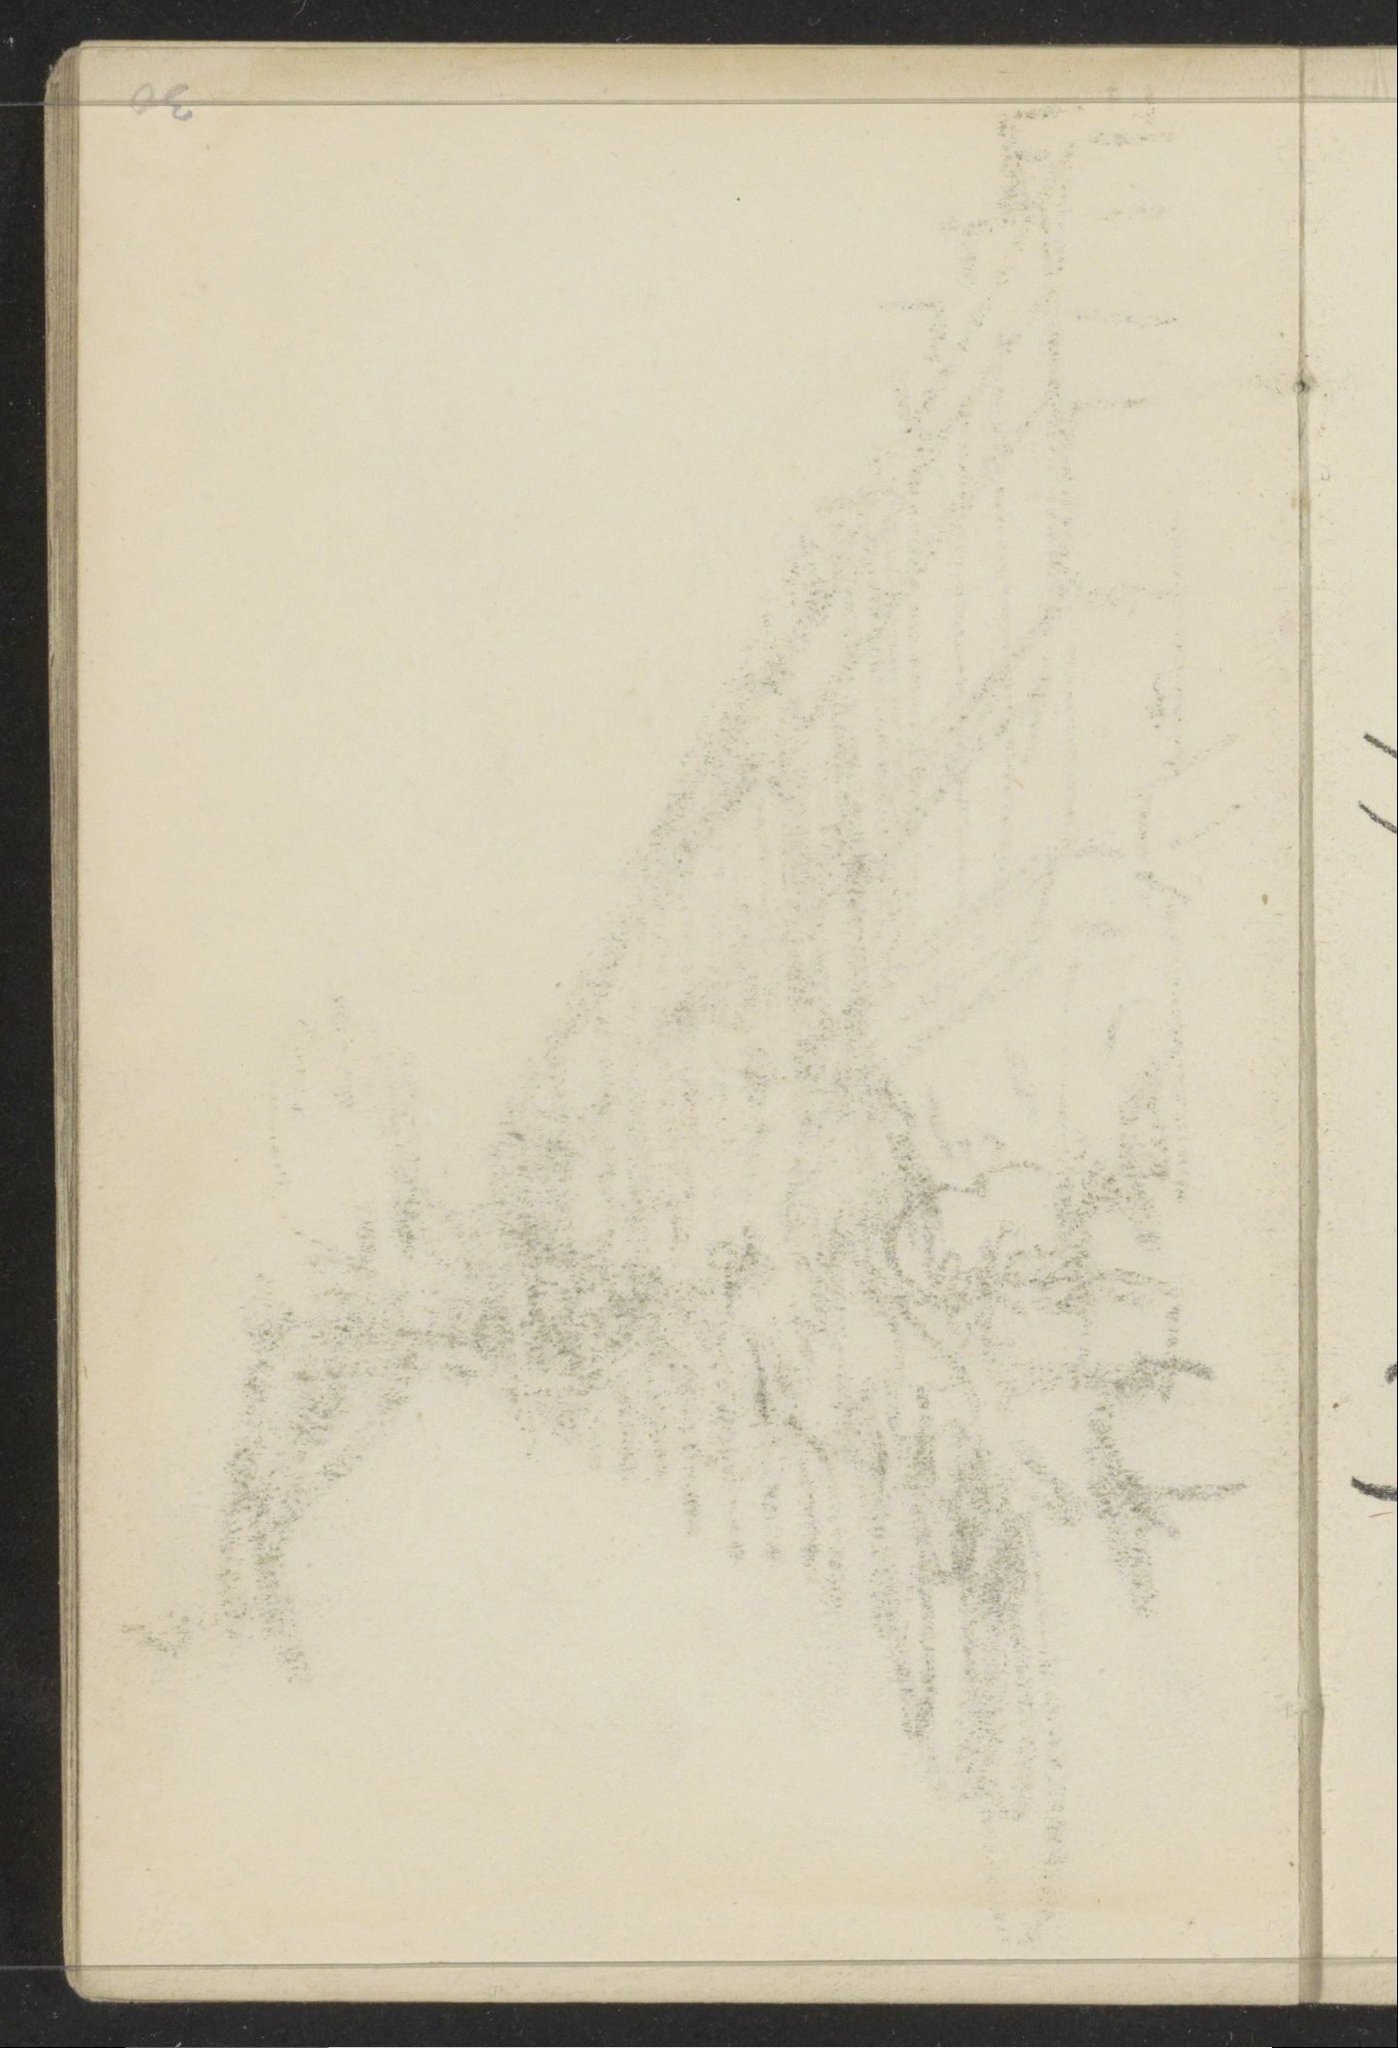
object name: sketchbook leaf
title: Abklatsch van de krijttekening op blad 14 recto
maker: isaac israels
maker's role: draughtsman, painter, print maker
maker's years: 1865-1934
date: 1887-1934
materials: paper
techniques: printmaking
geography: paris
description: Blad 13 verso uit schetsboek LIX met 21 bladen.